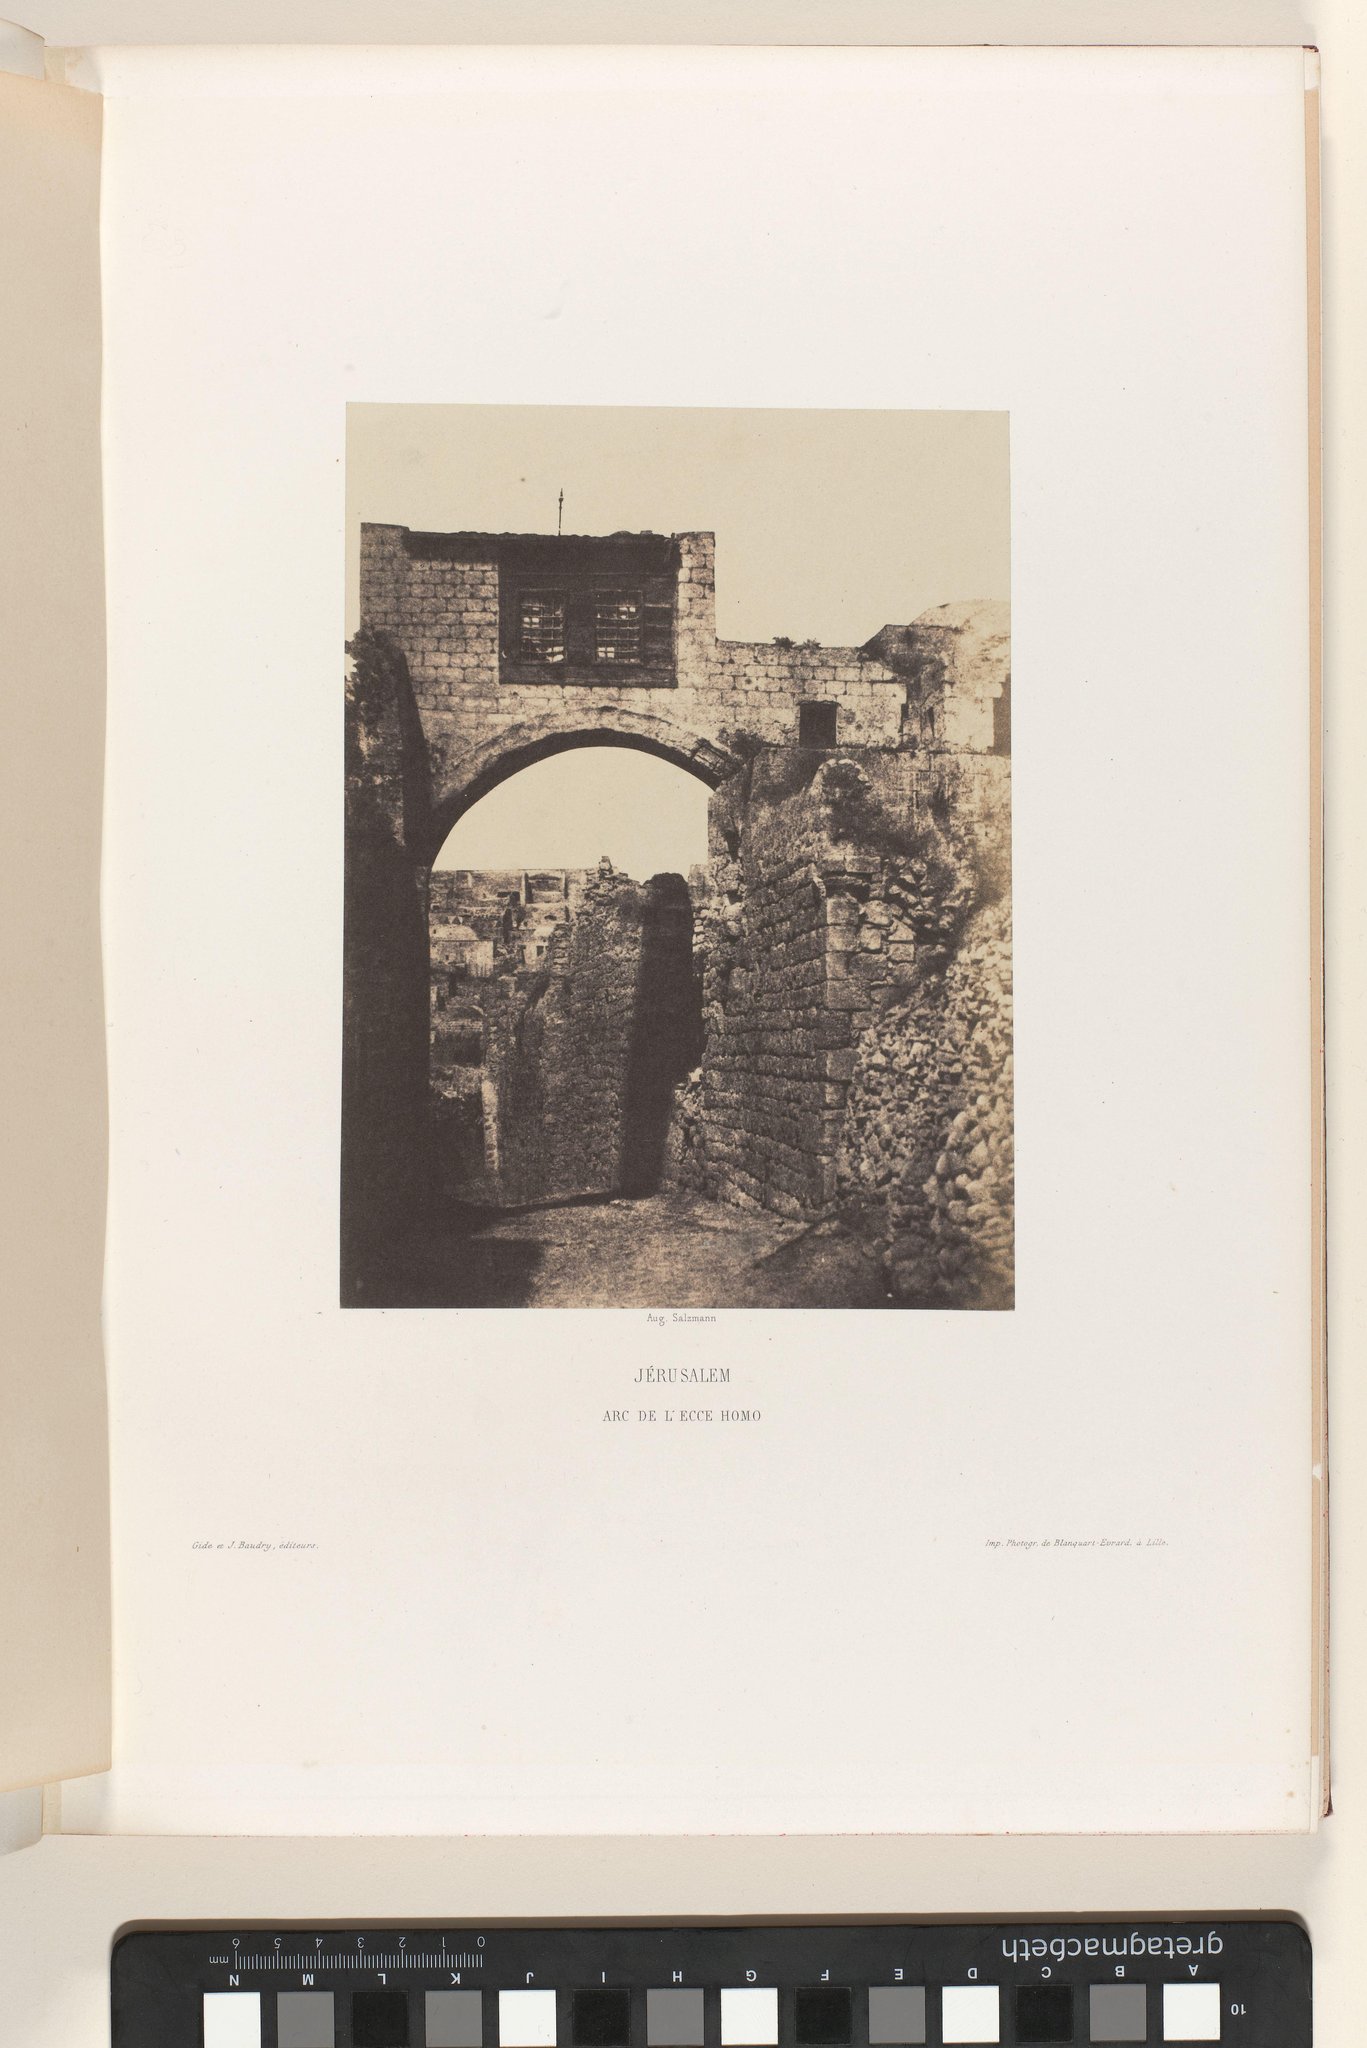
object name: photograph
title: Boog van Ecce Homo, Jeruzalem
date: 1854-1856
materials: cardboard, paper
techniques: salted paper print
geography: jerusalem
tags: gate, entrance